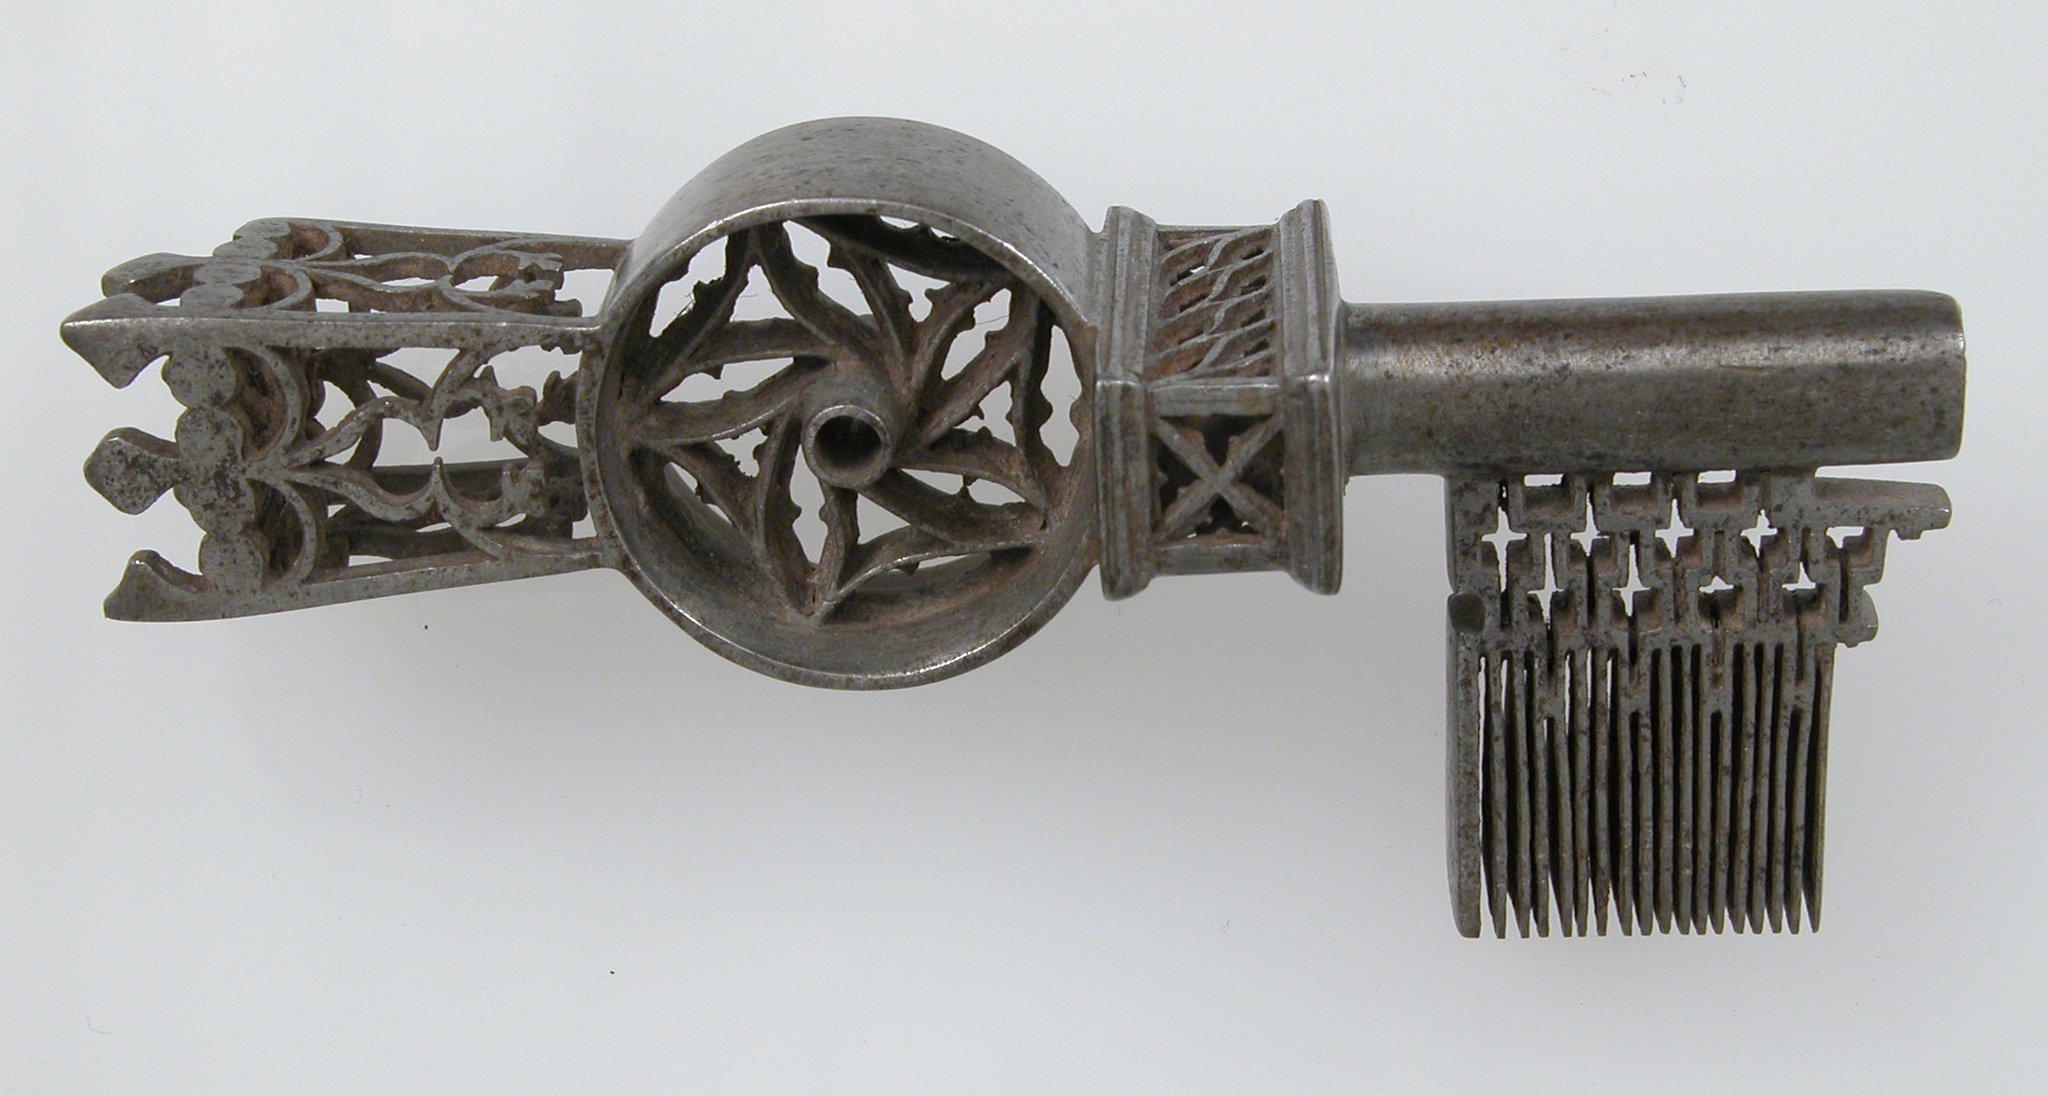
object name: key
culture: french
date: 1501-1600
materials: iron